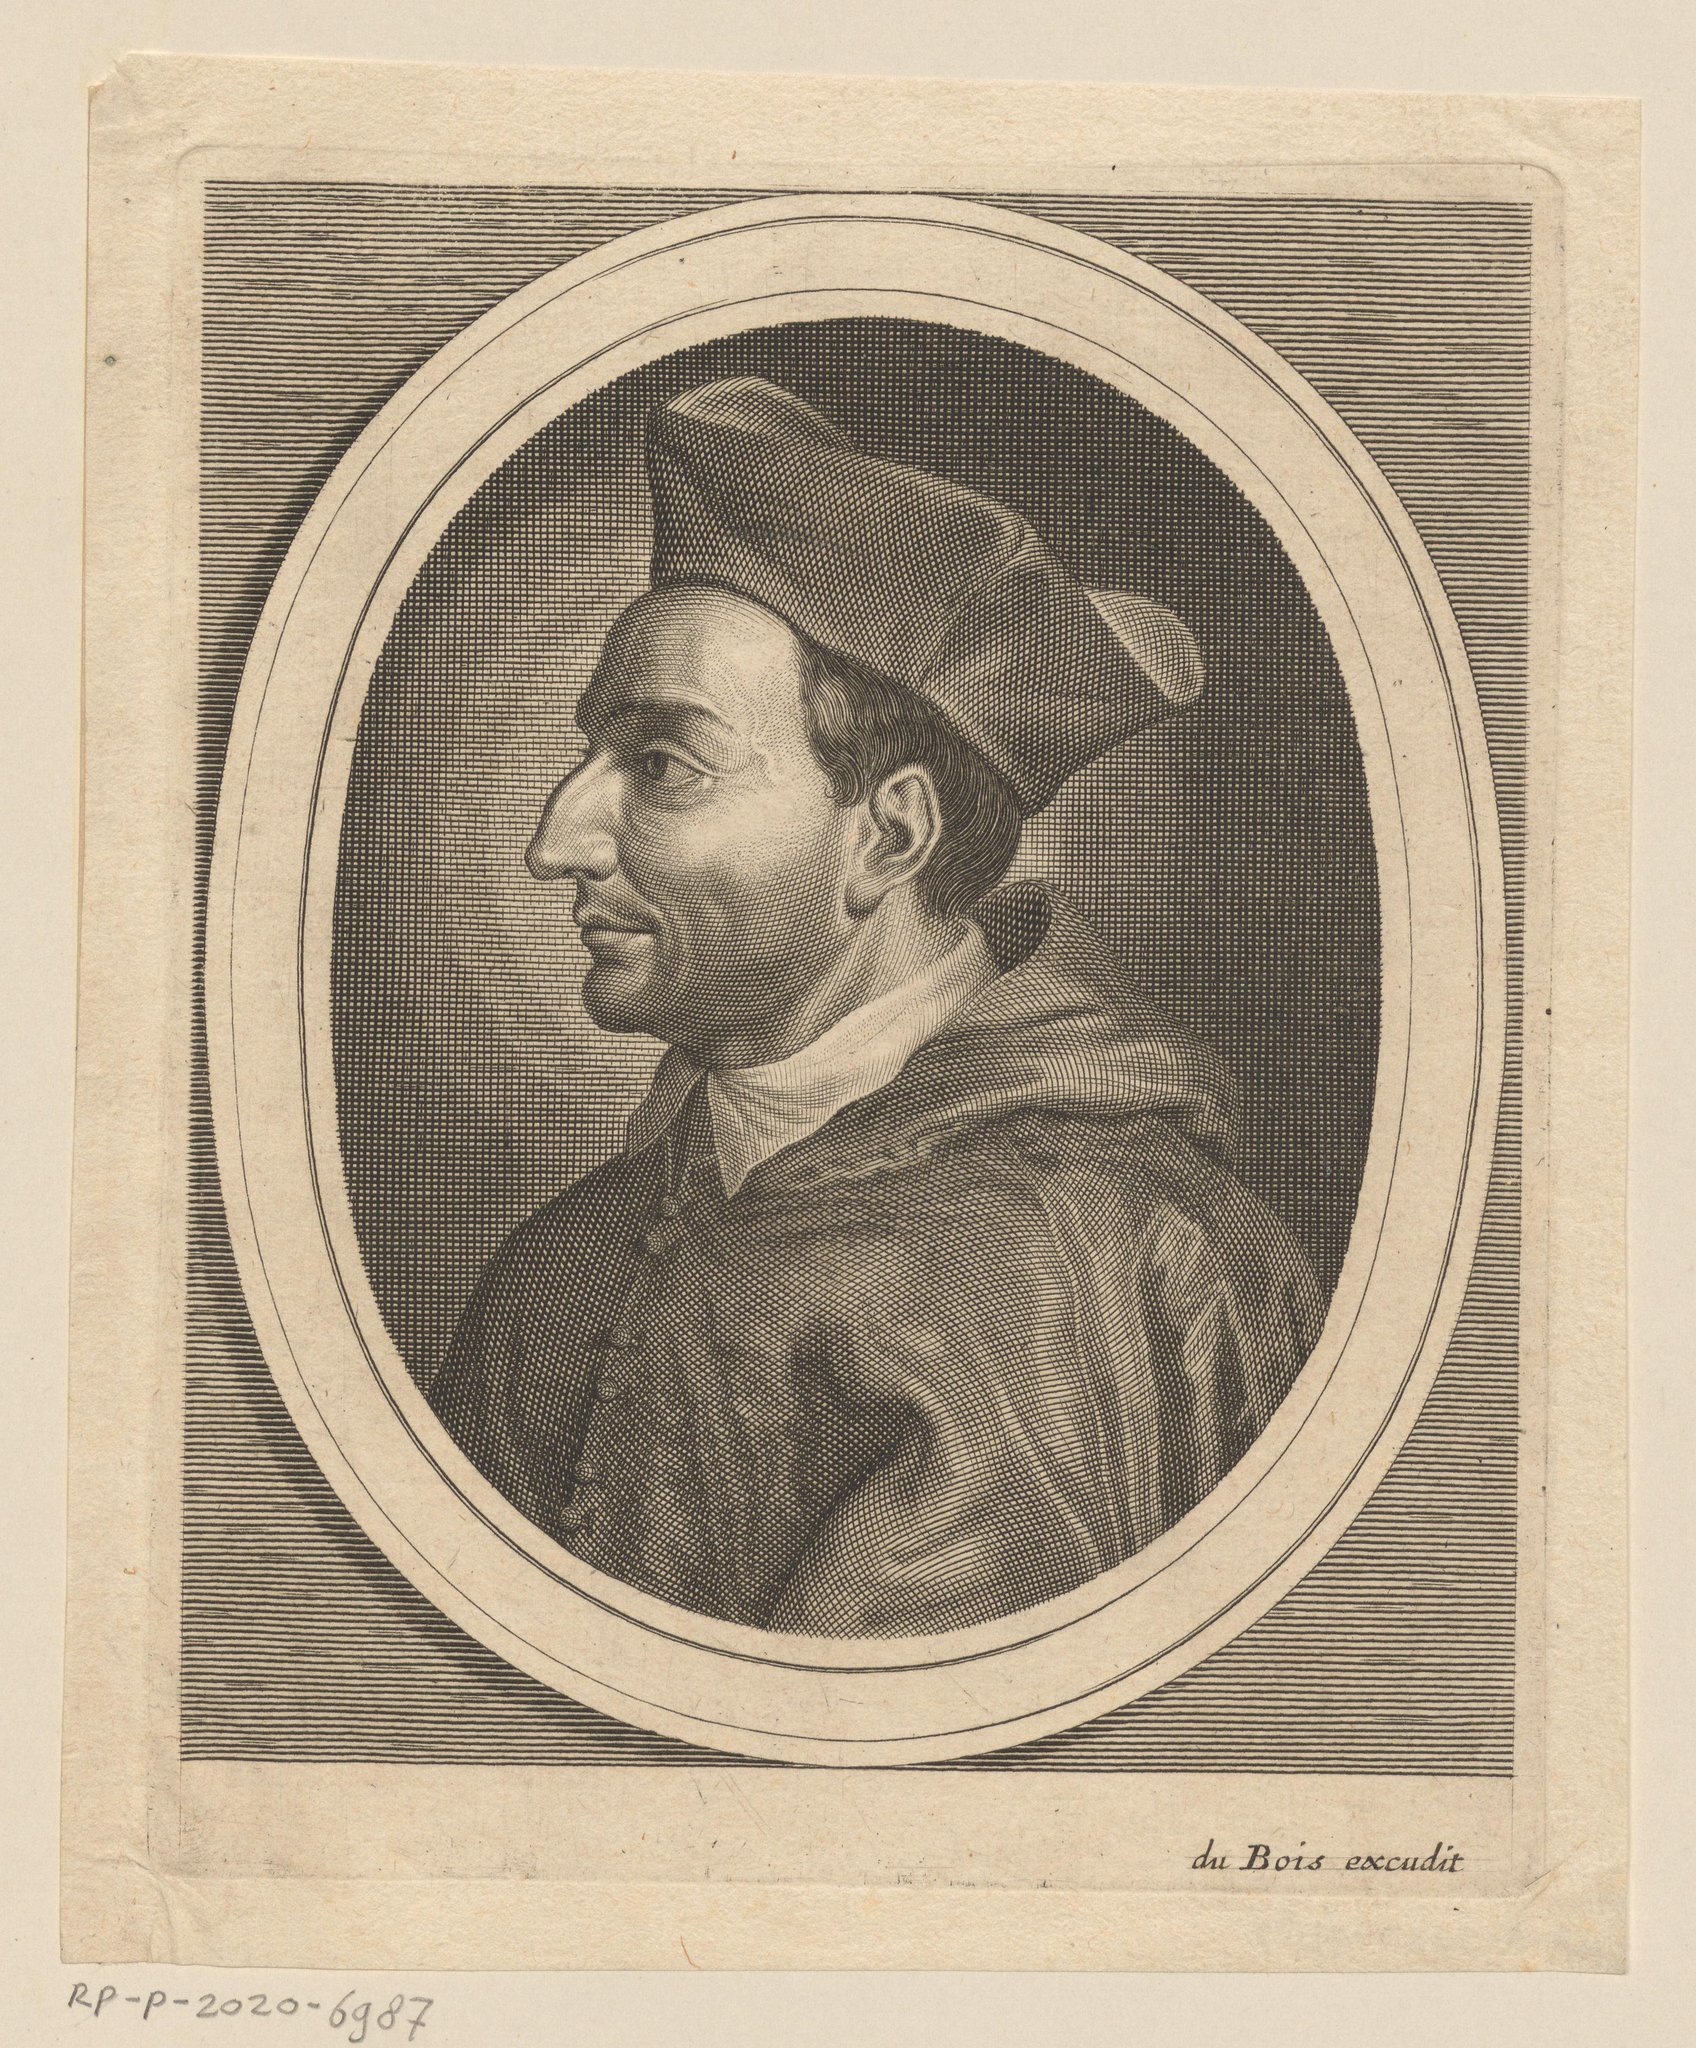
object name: print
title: Portret van Cornelius Jansenius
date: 1600-1699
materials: paper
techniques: engraving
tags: cornelius jansenius, archbishop, bishop, etc. (roman catholic), historical persons